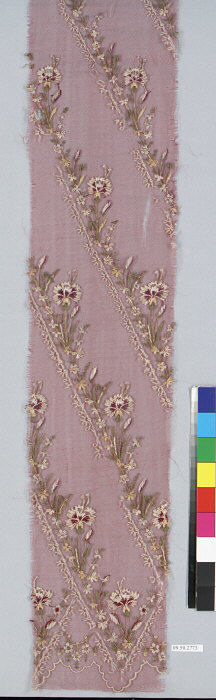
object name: fragment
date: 1801-1900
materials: silk, wool